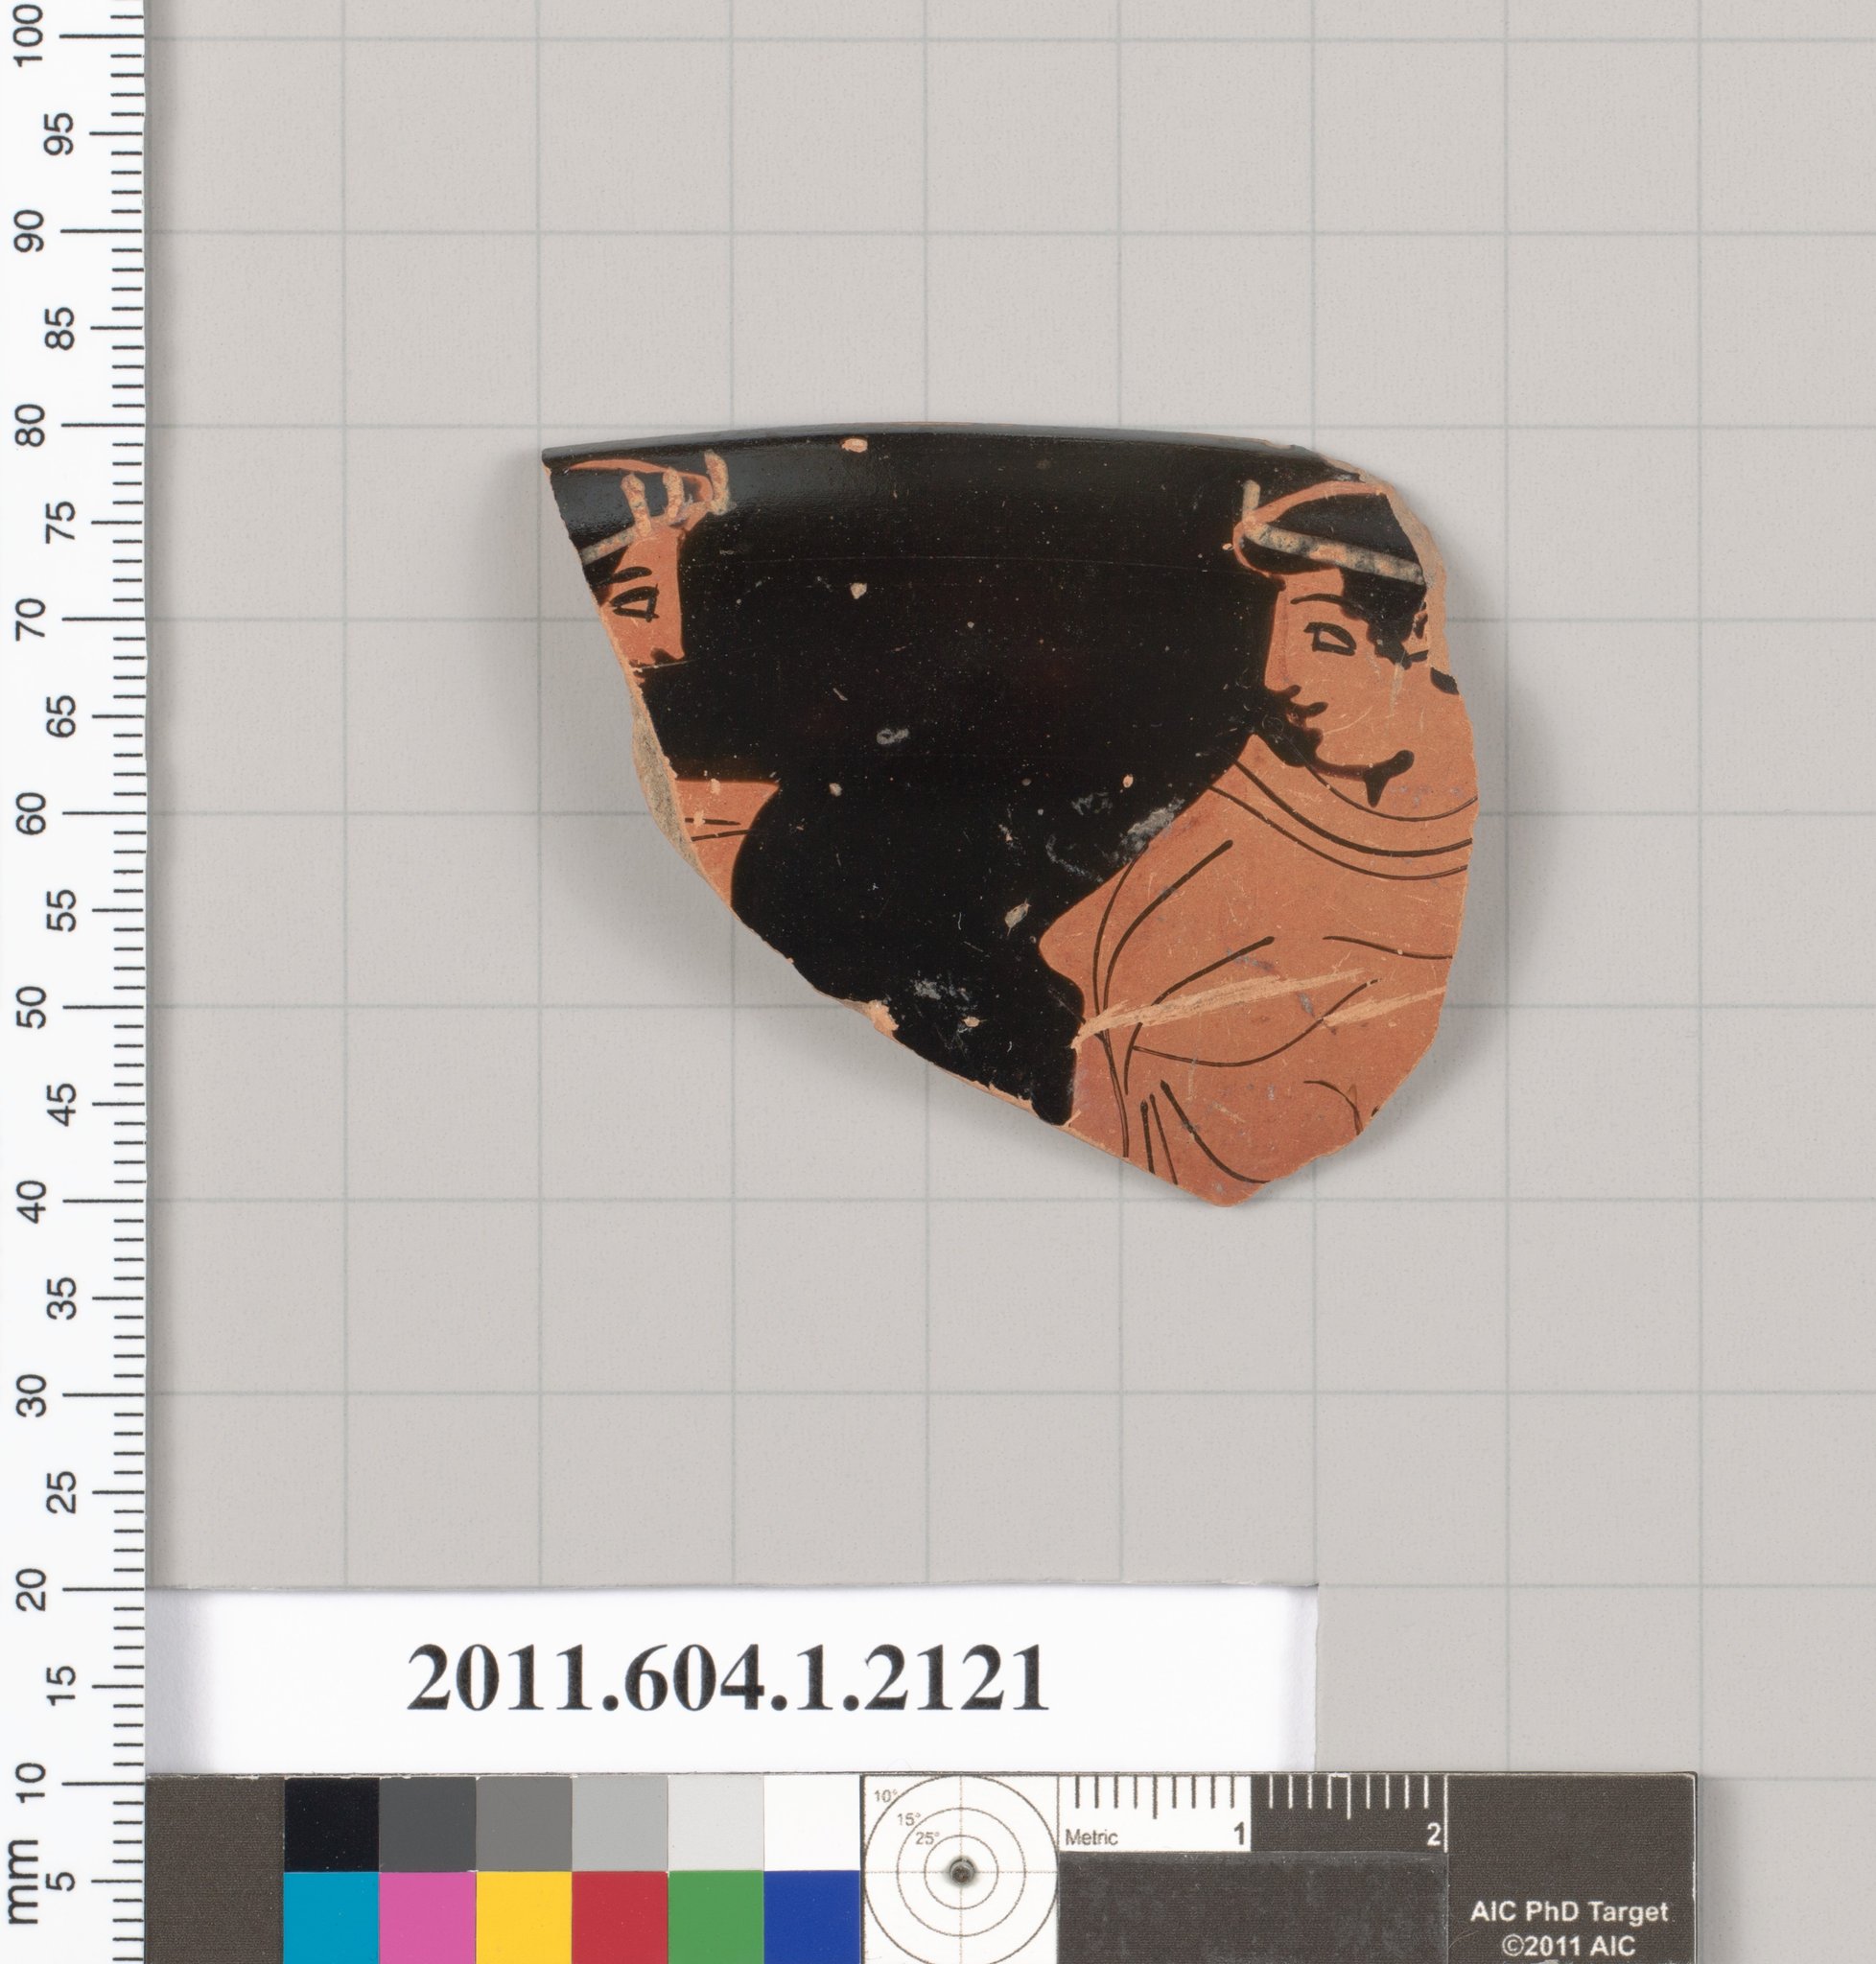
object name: kylix fragment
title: Terracotta rim fragment of a kylix (drinking cup)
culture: greek, attic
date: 467-435 BCE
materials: terracotta